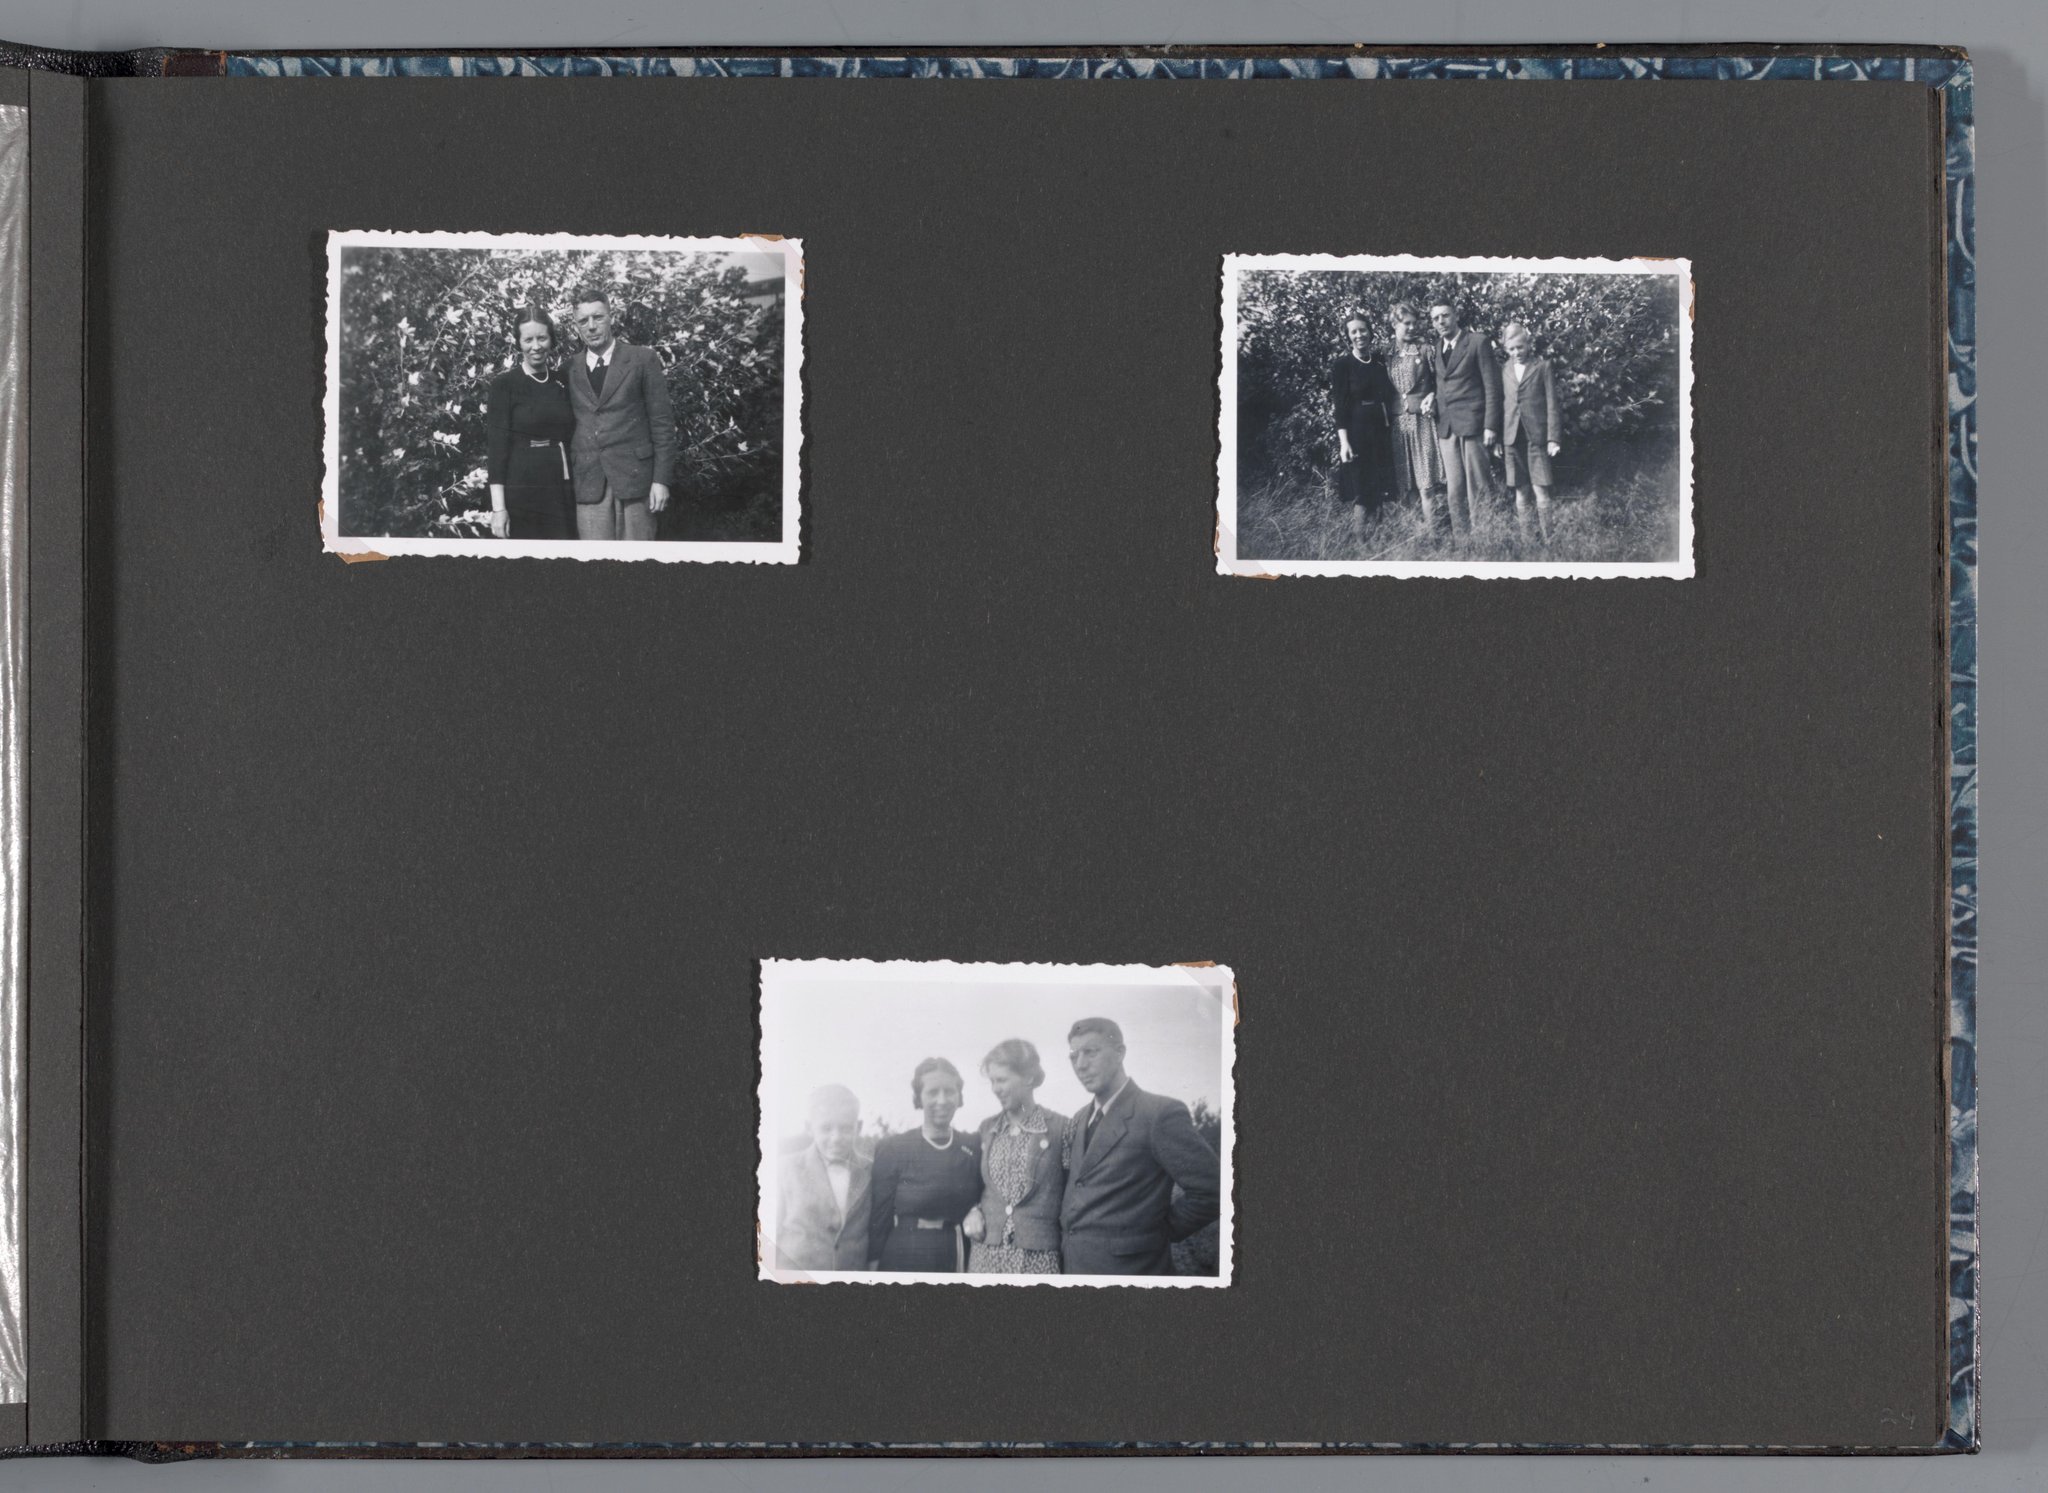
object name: album leaf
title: Famile Vonk uit Nederlands-Indië gerepatrieerd terug in Nederland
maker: Anonymous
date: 1909-1946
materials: cardboard, photographic support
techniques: gelatin silver print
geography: bergen op zoom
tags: jet vonk, r.h. vonk, family group, especially parents with their child(ren), bergen op zoom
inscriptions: date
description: Albumblad met drie foto's van het gezin Vonk, na terugkeer in Nederland, herenigd met familie in Bergen op Zoom, in september 1946. Onderdeel van het familiealbum van Jet Vonk uit Celebes.